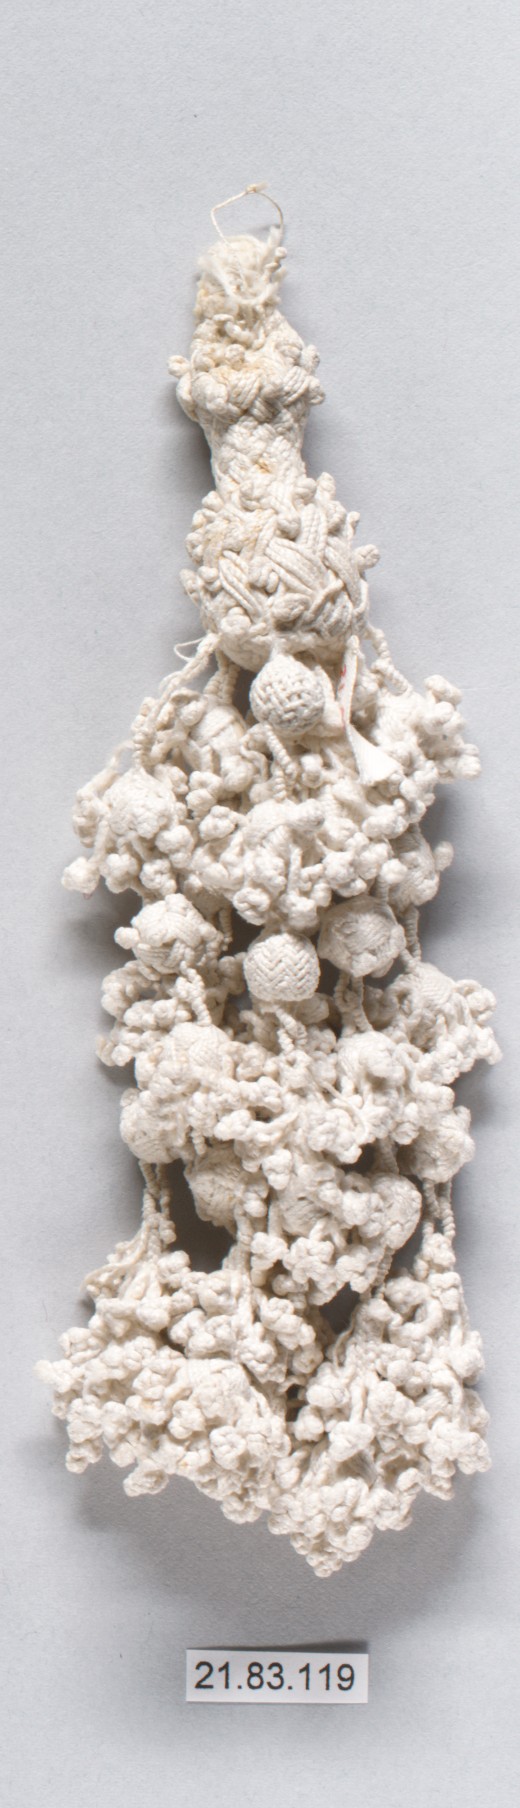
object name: tassel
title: Pair of tassels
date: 1601-1700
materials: linen